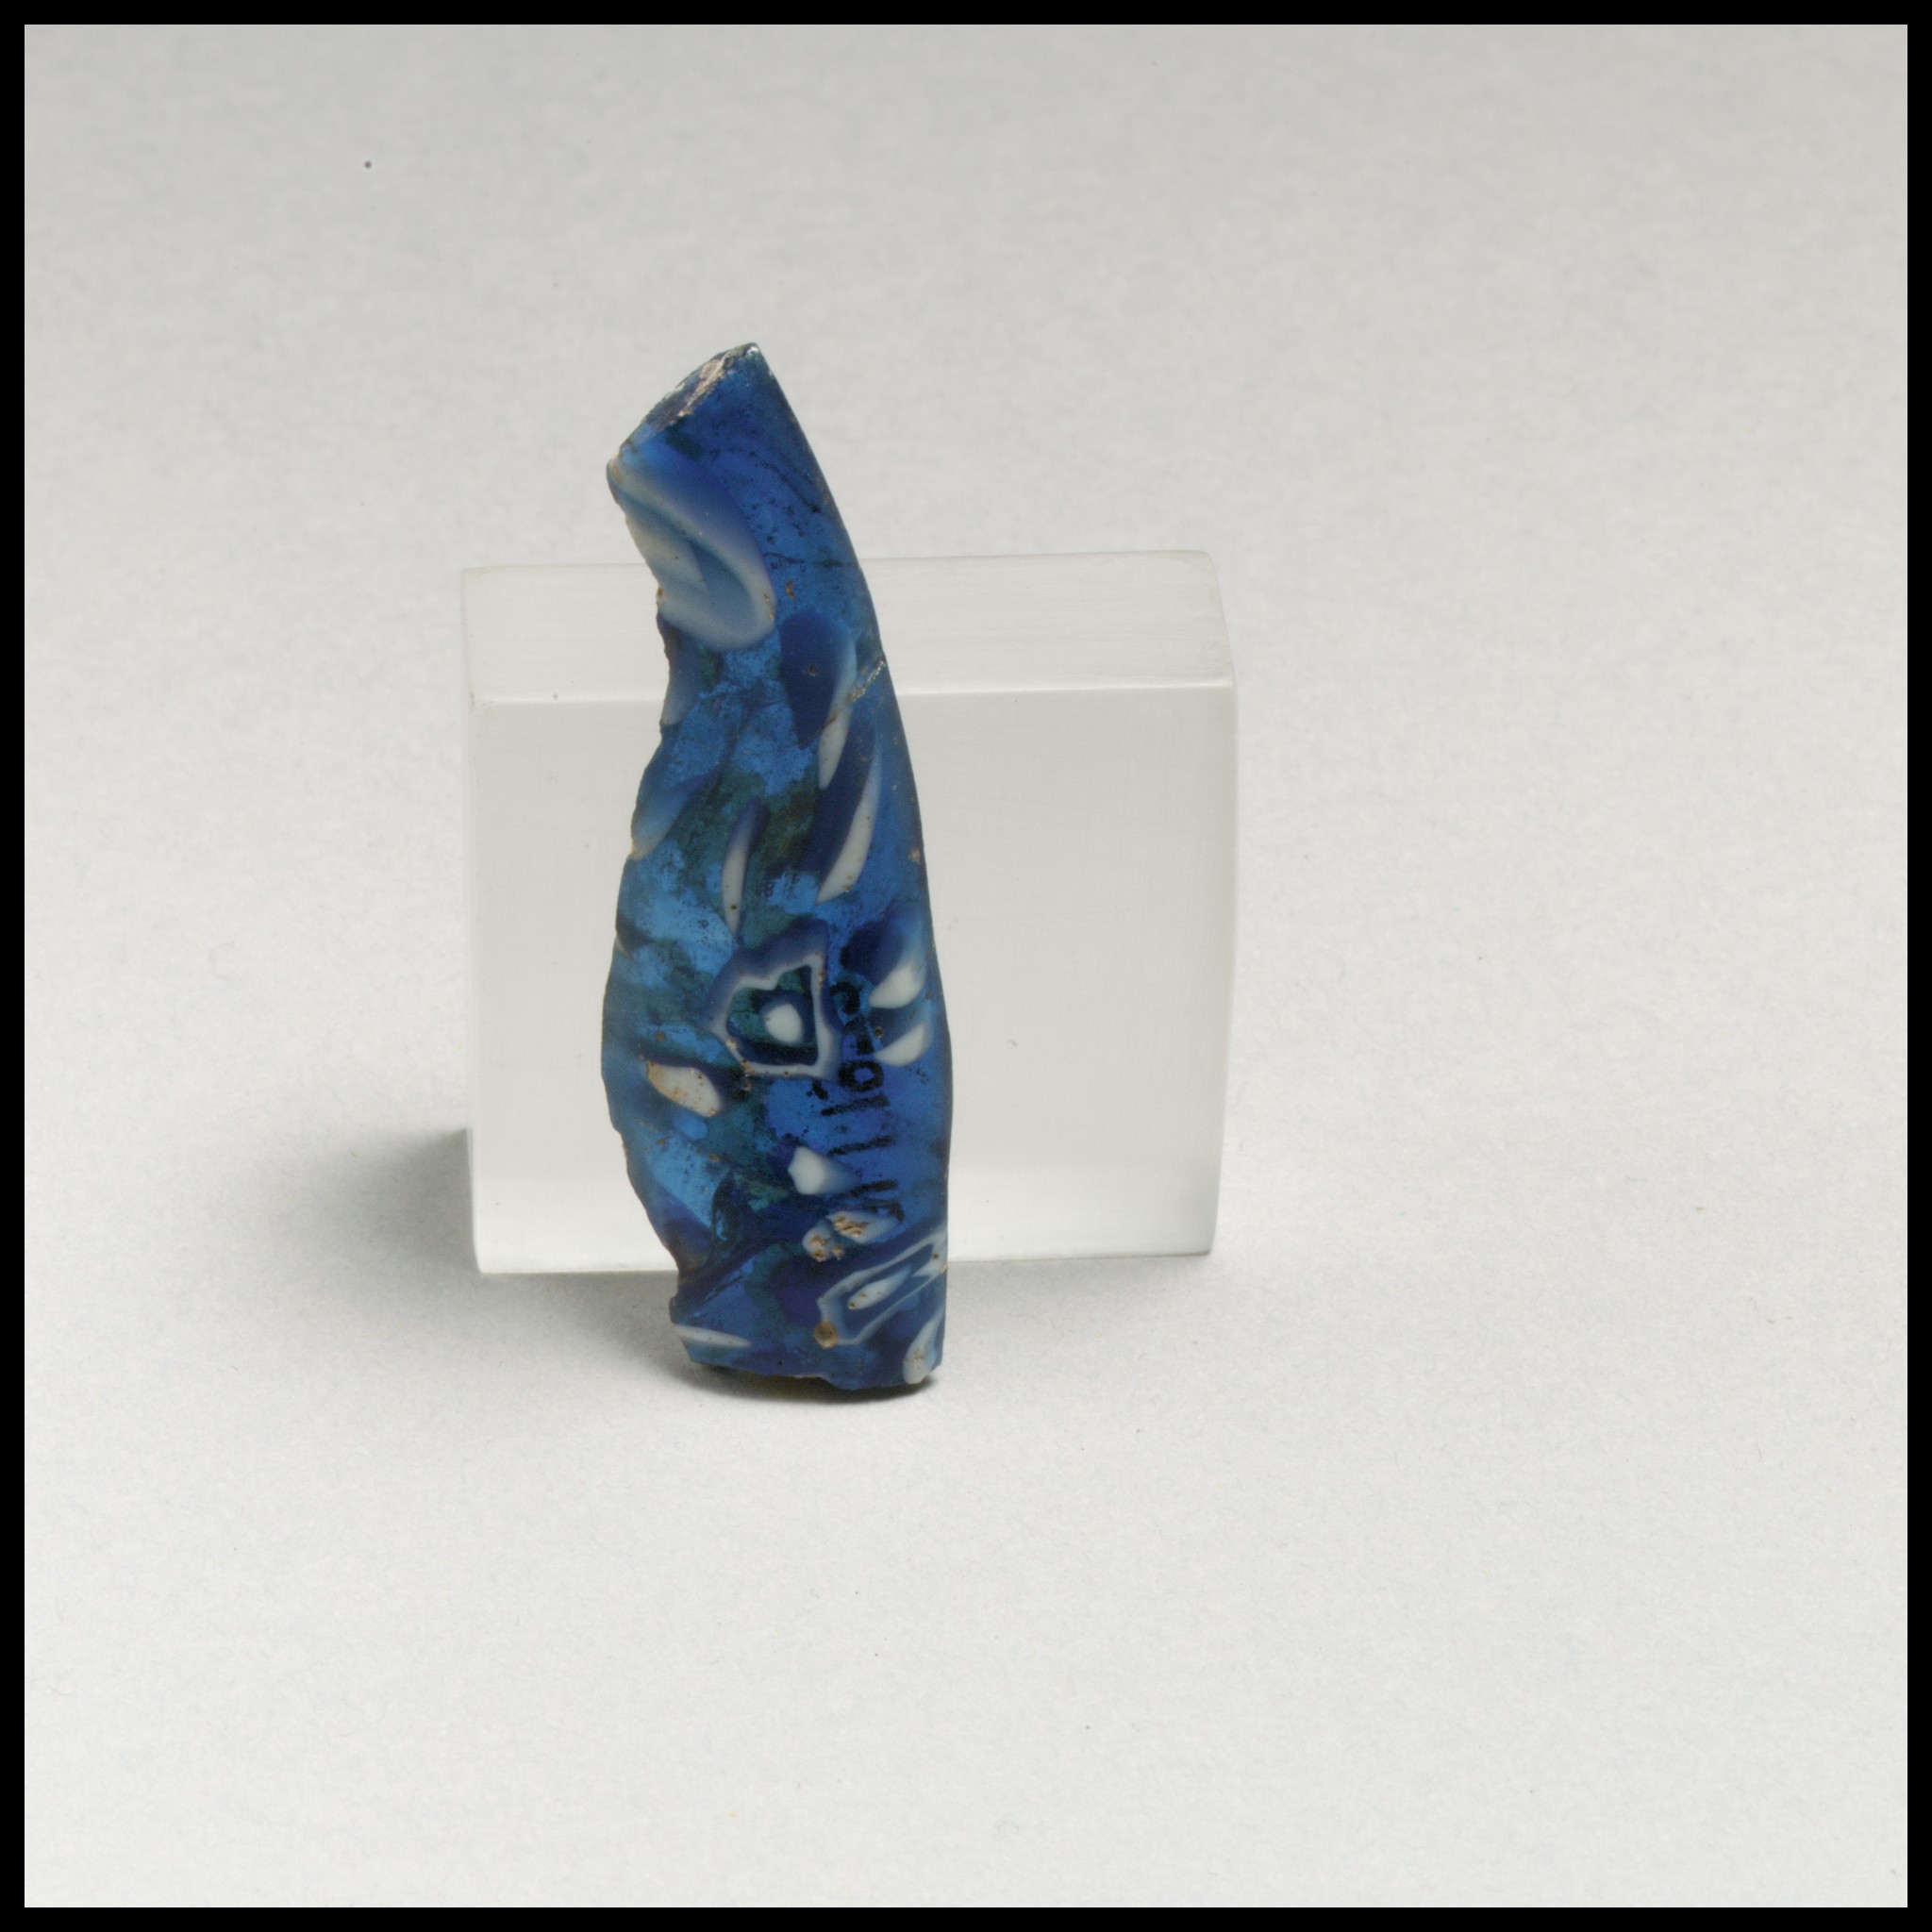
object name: fragment, mosaic bowl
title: Glass mosaic bowl fragment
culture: roman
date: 34 BCE-33 CE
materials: glass